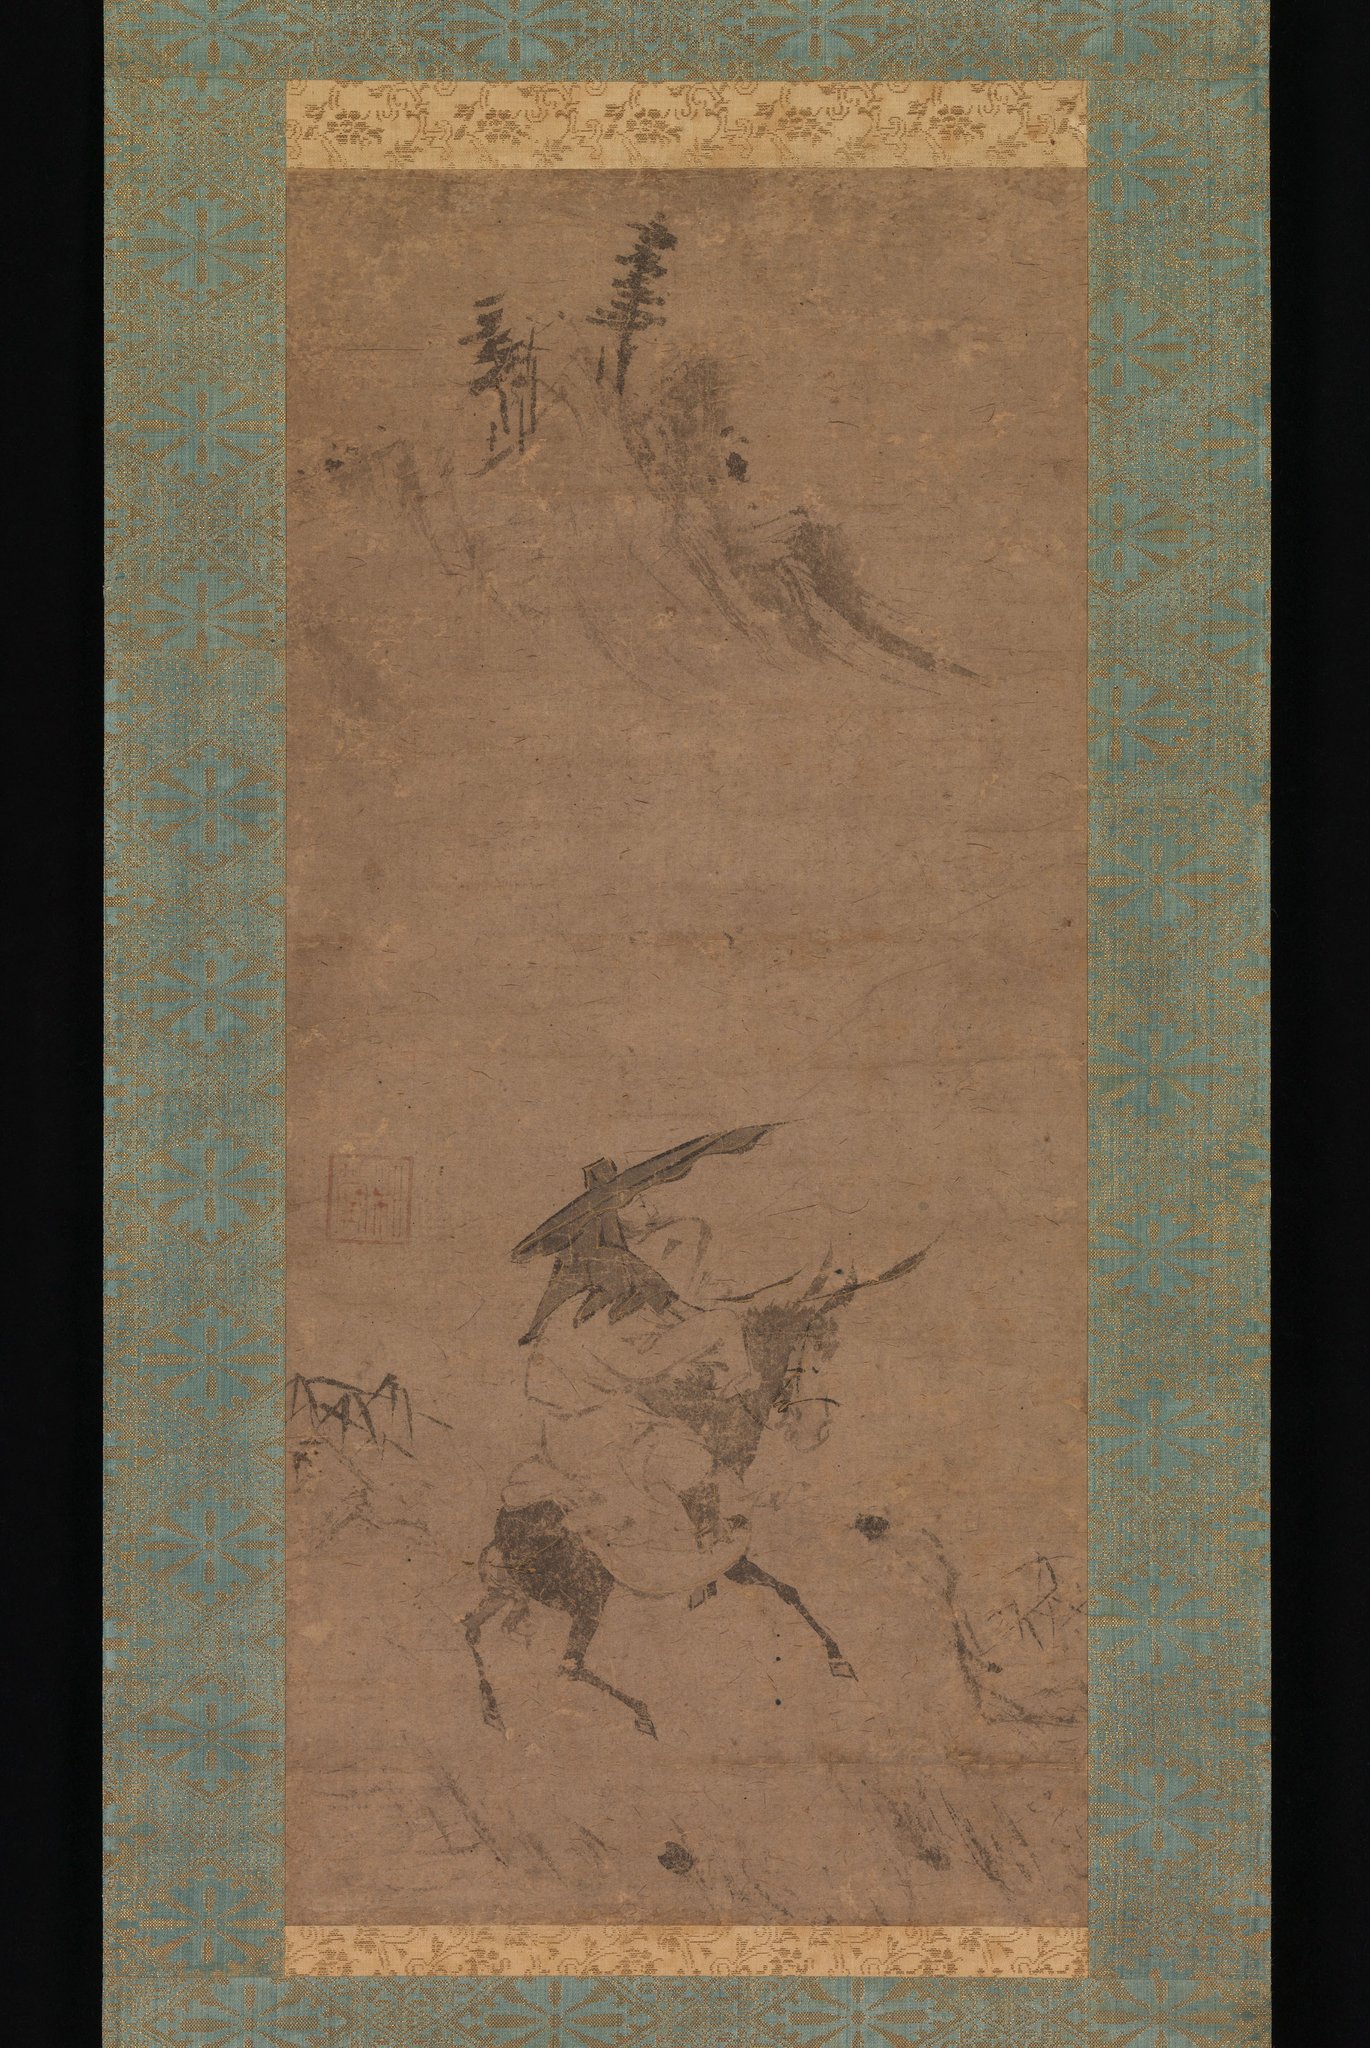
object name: hanging scroll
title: Su Shi Riding a Donkey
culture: japanese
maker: bokudō sojun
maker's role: artist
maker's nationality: japanese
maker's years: 1373-1459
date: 1401-1433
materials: gold, ink, paper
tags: men,donkeys